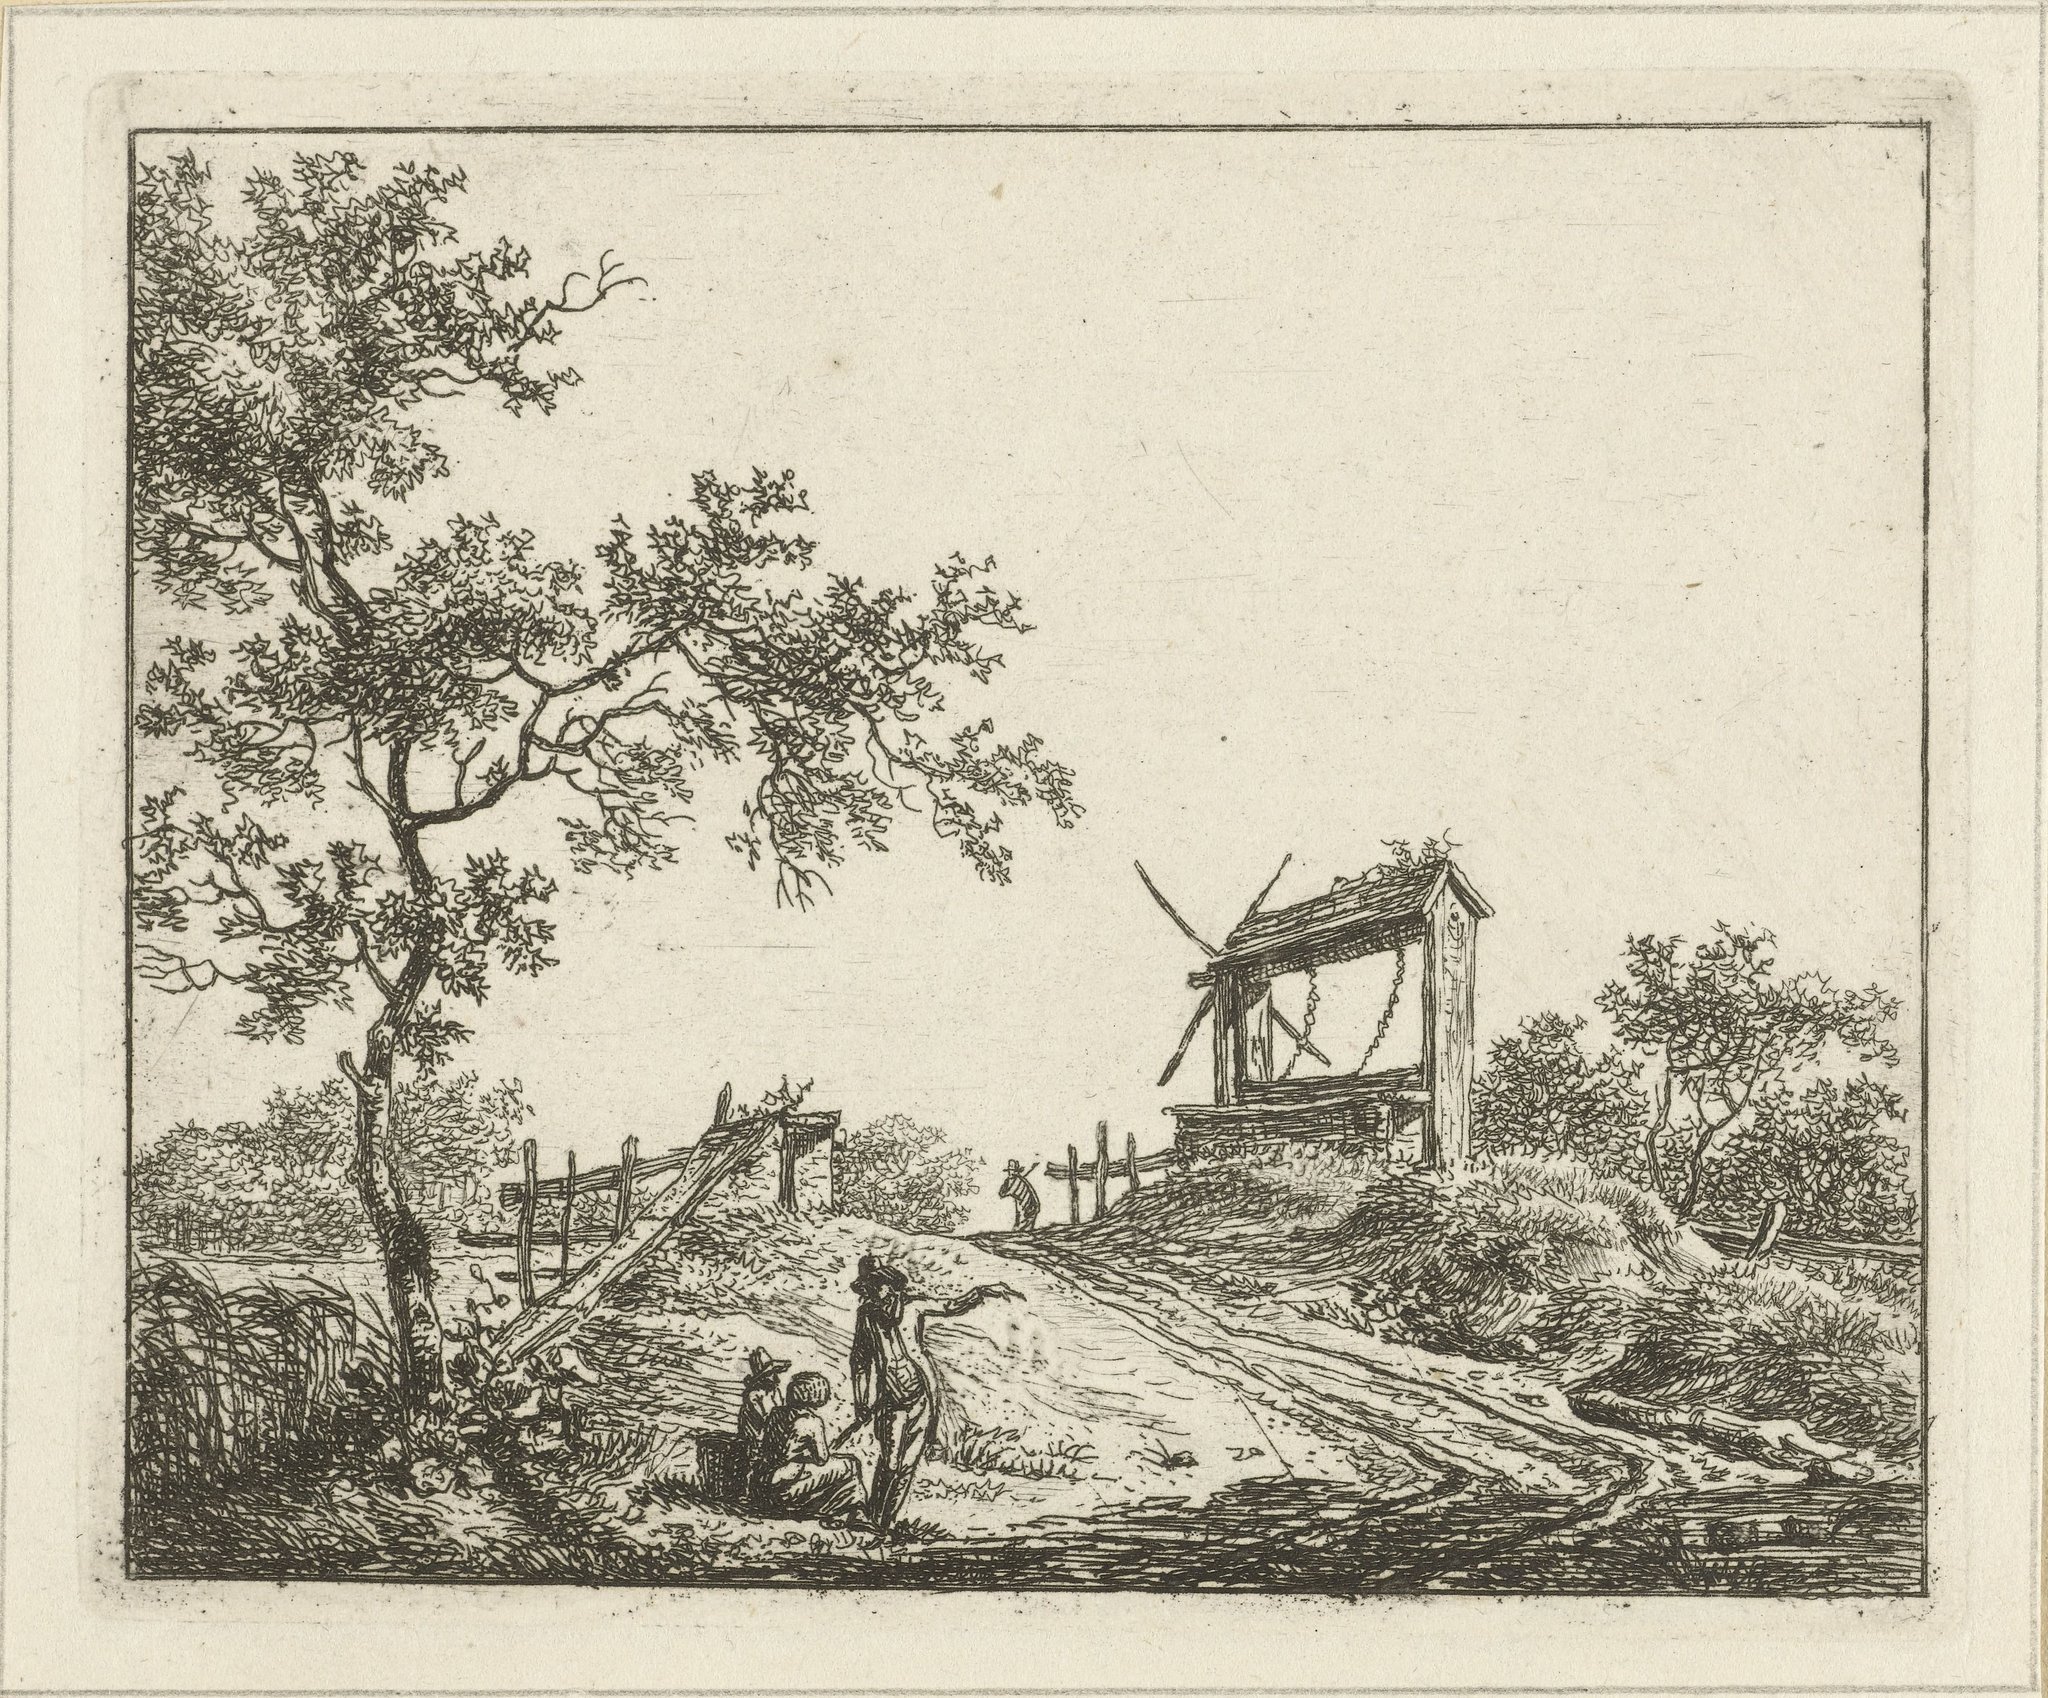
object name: print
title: Landschap met waterput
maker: hermanus fock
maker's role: conservator, draughtsman, painter, print maker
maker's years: 1766-1822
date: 1781-1822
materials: paper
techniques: etching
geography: amsterdam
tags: well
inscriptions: collector's mark: Lugt 2228, collector's mark: Lugt 924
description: Landschap met een waterput. Op de voorgrond, bij een boom, staat een man met uitgestrekte arm bij twee zittende figuren.